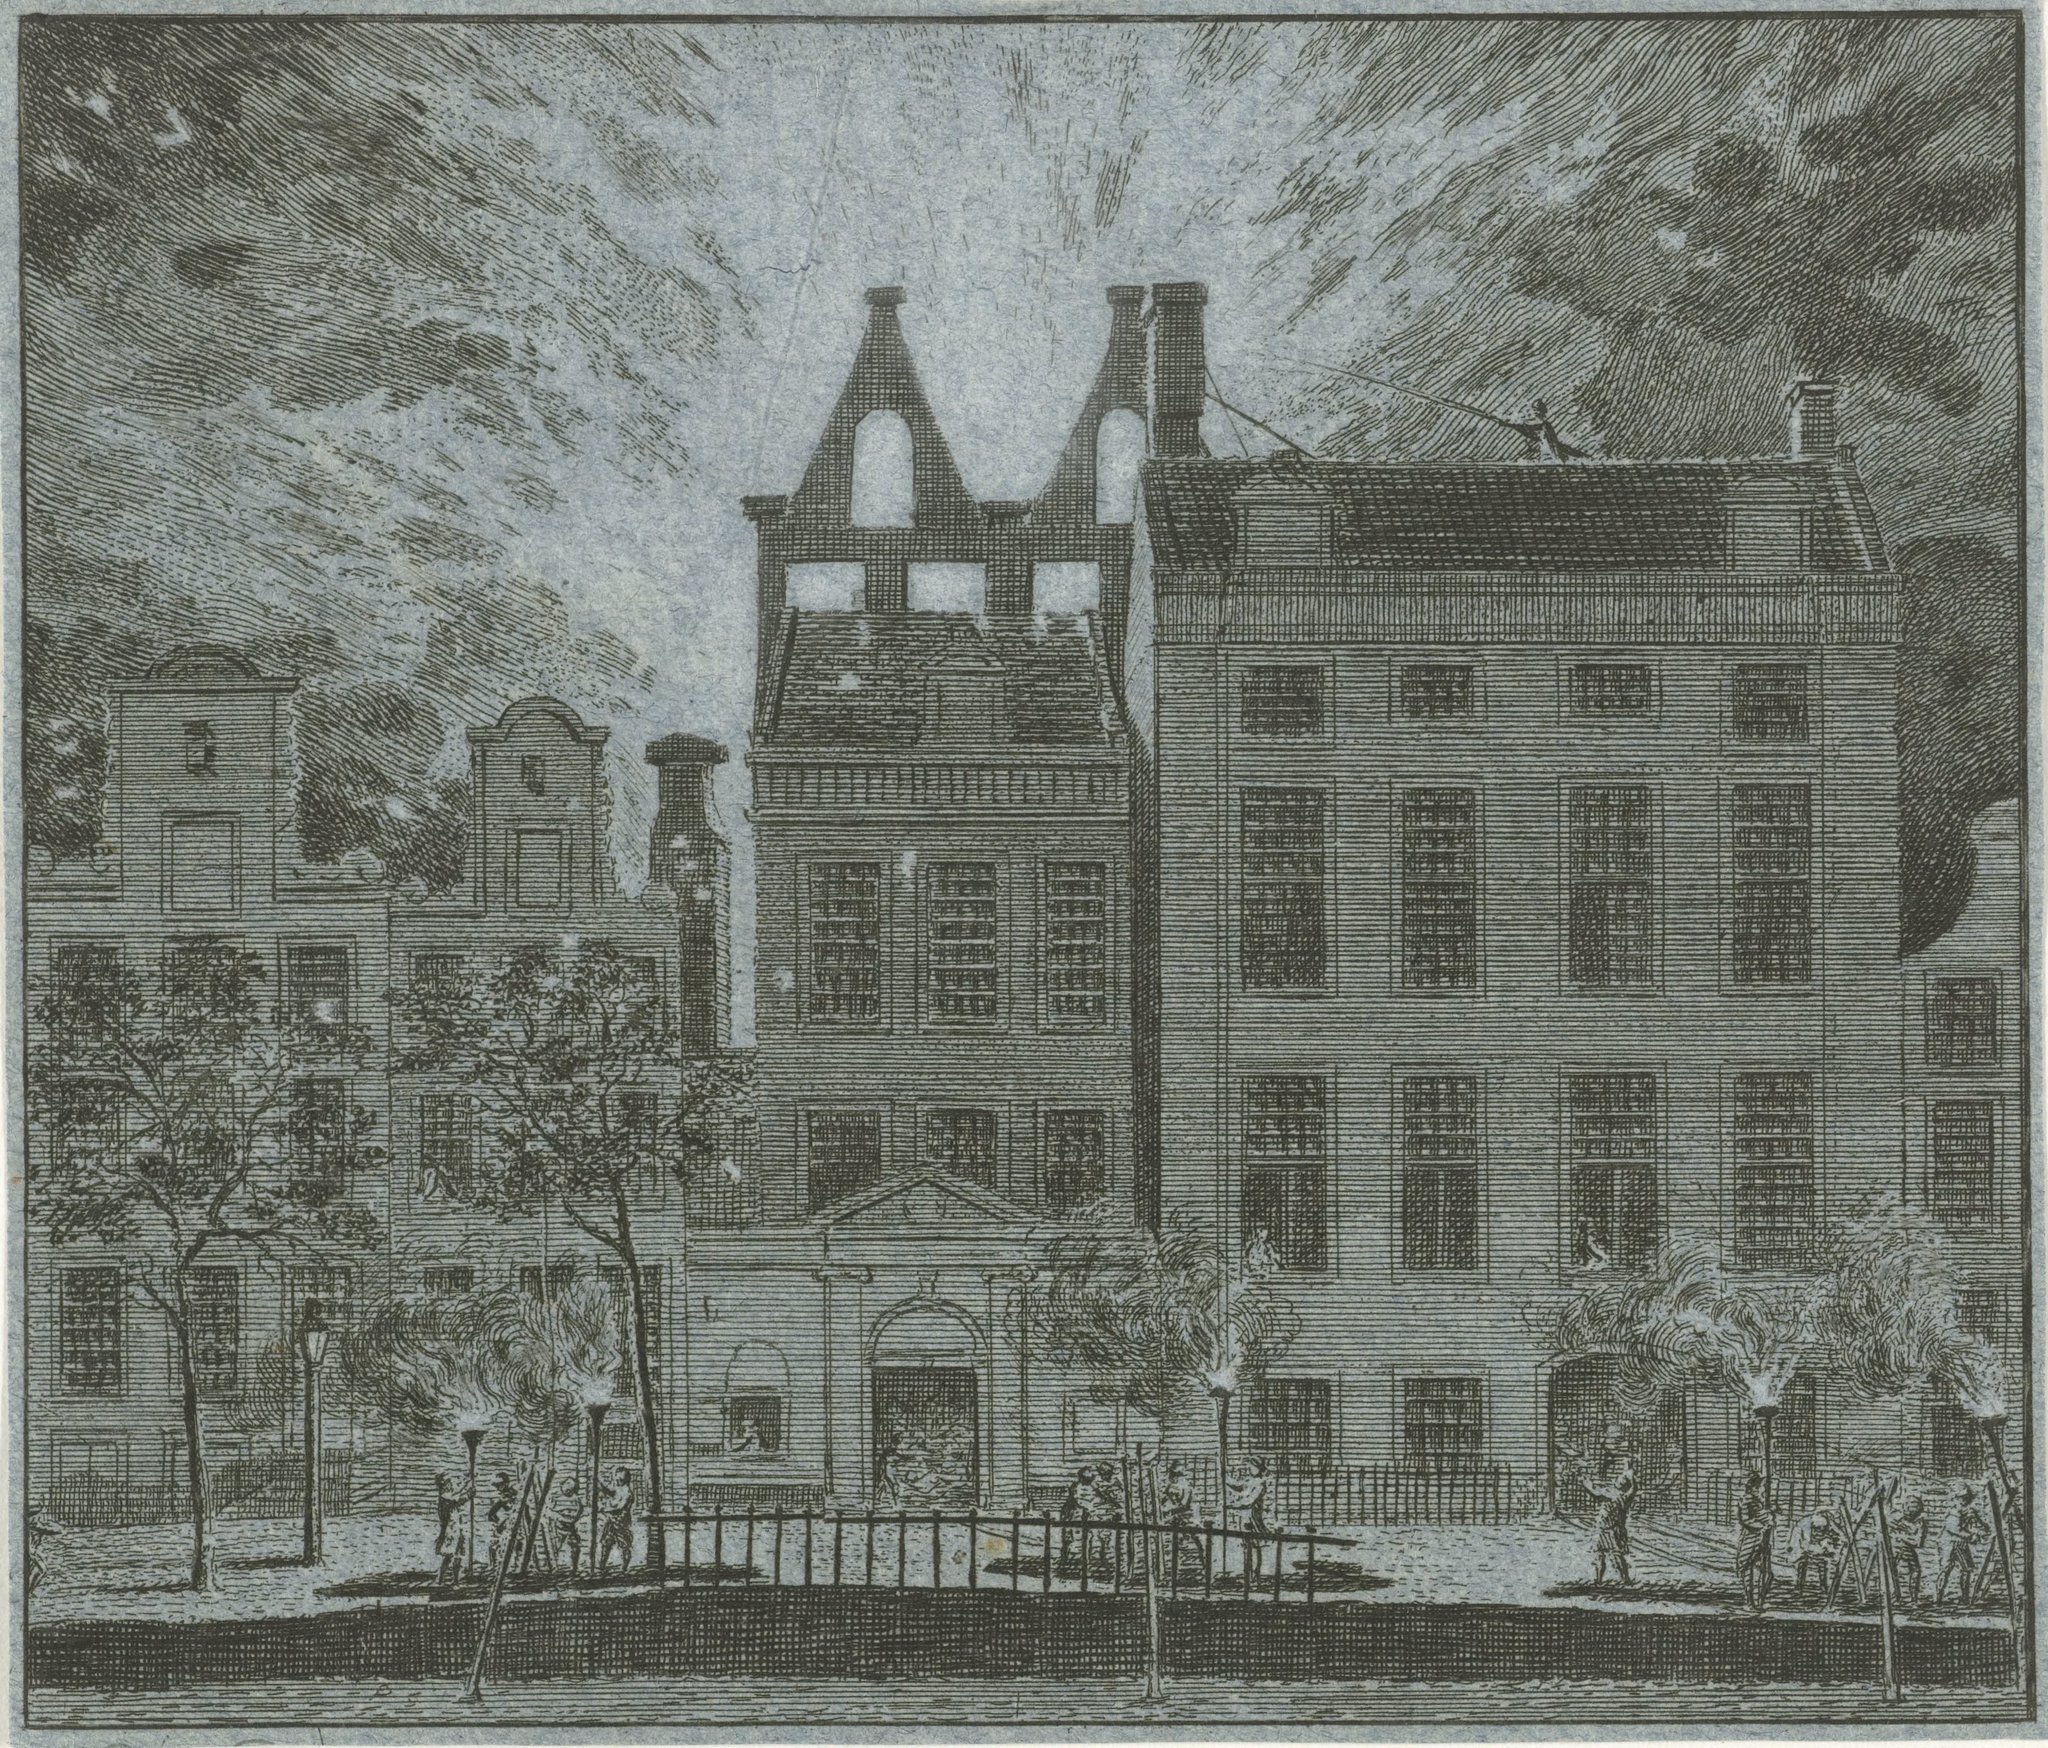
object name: print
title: Brand van de schouwburg aan de Keizersgracht te Amsterdam, 1772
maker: cornelis van noorde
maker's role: draughtsman, print maker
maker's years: 1731-1795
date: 1772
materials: paper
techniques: engraving, etching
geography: northern netherlands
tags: on fire, ablaze, theatre, theatrical performance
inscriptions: collector's mark: Lugt 2228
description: De uitslaande brand in de Amsterdamse Schouwburg op de Keizersgracht op 11 mei 1772.